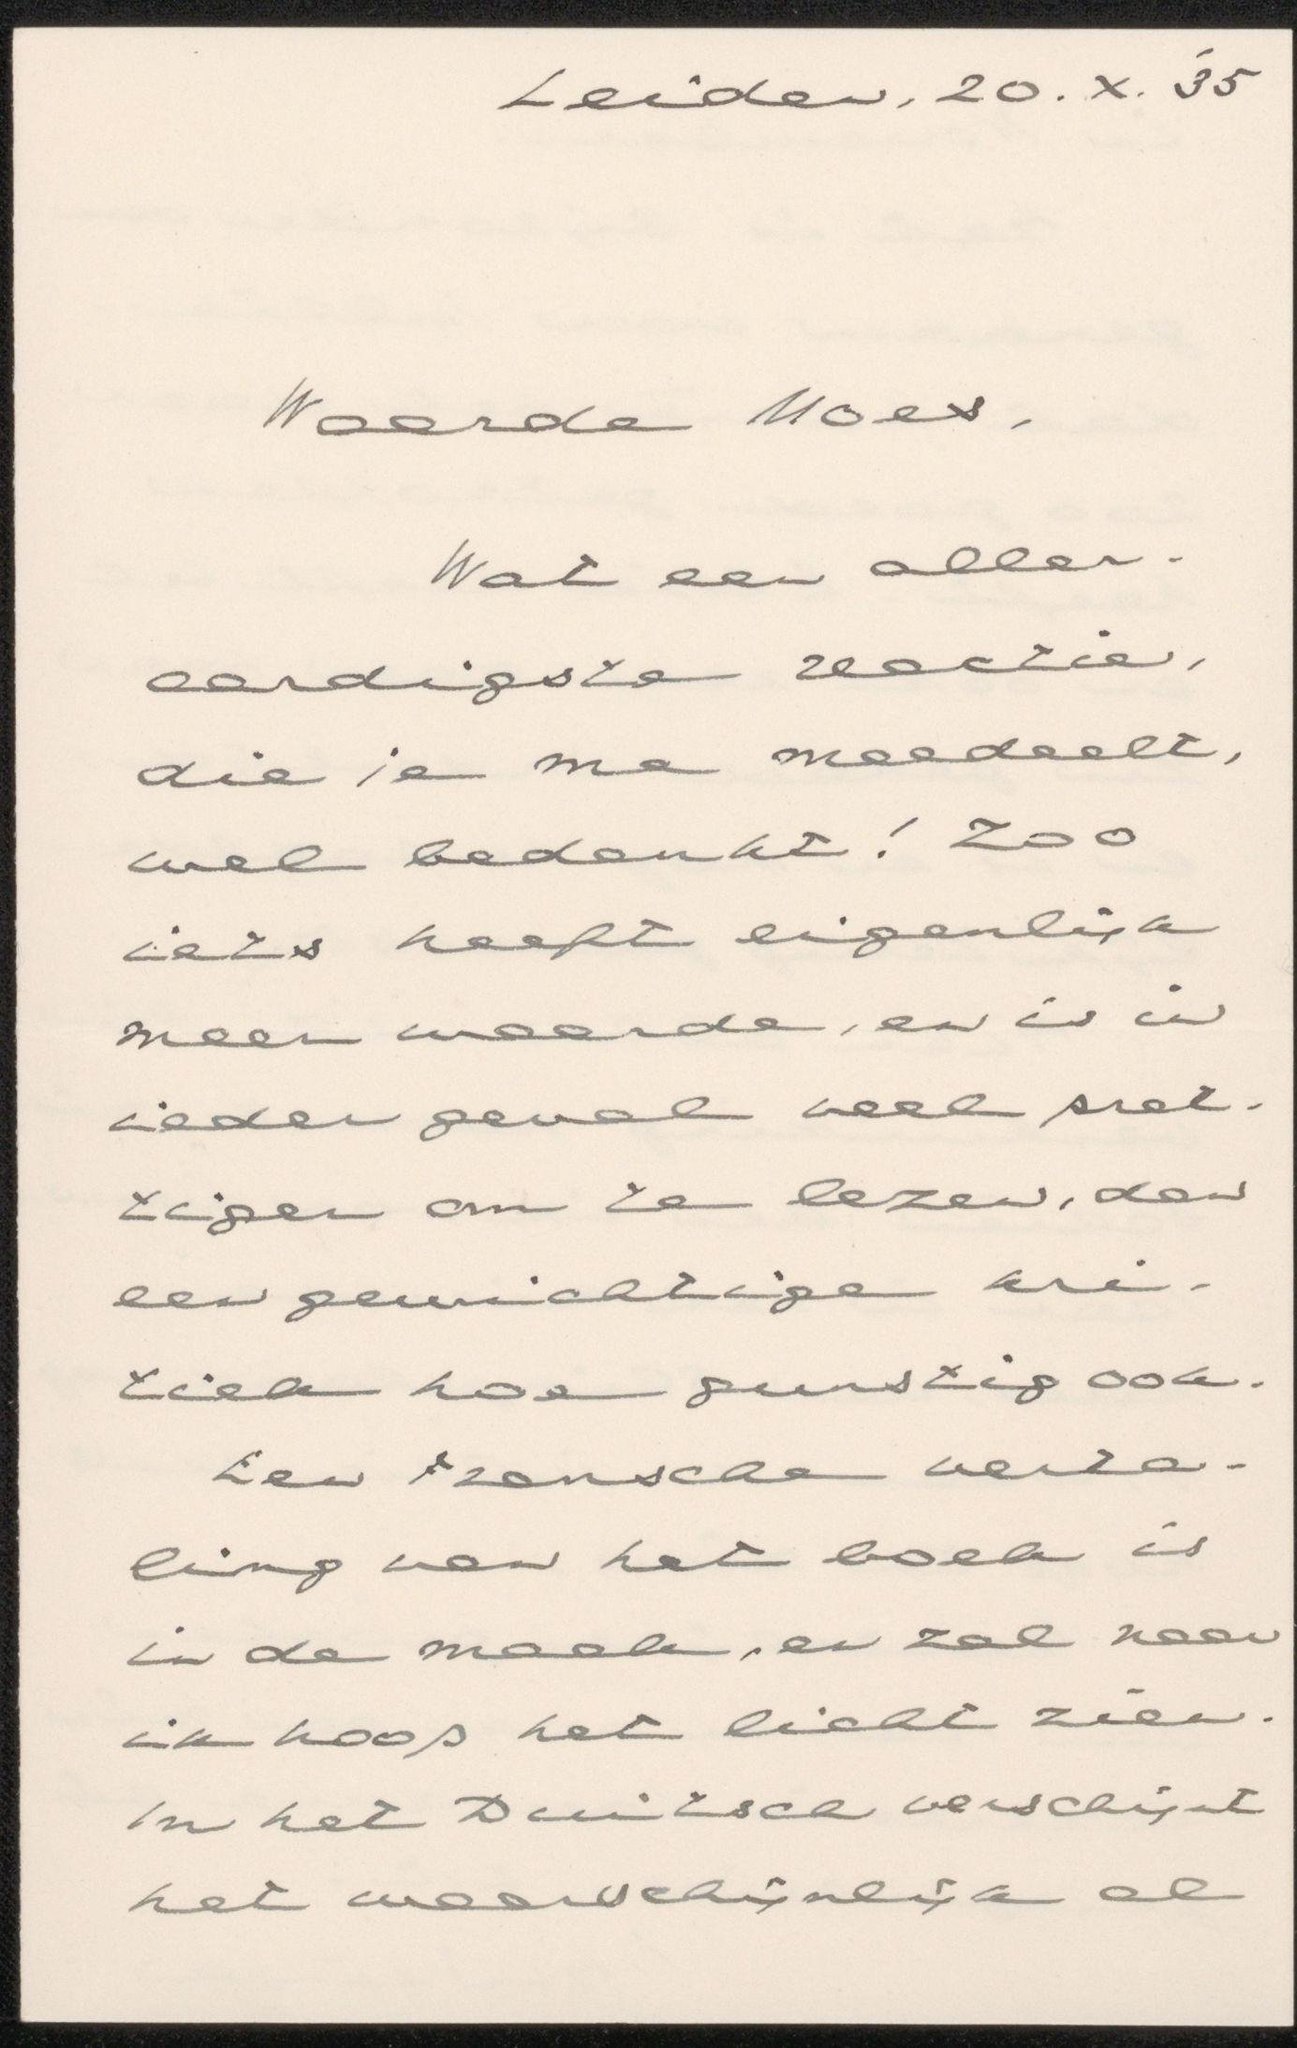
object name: letter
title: Brief aan Christiaan Moes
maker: johan huizinga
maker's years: 1872-1945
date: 1935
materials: ink, paper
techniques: pen, writing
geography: leiden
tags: engineer, passions, emotions, affections, family life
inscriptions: watermark, collector's mark: ‘RPK’